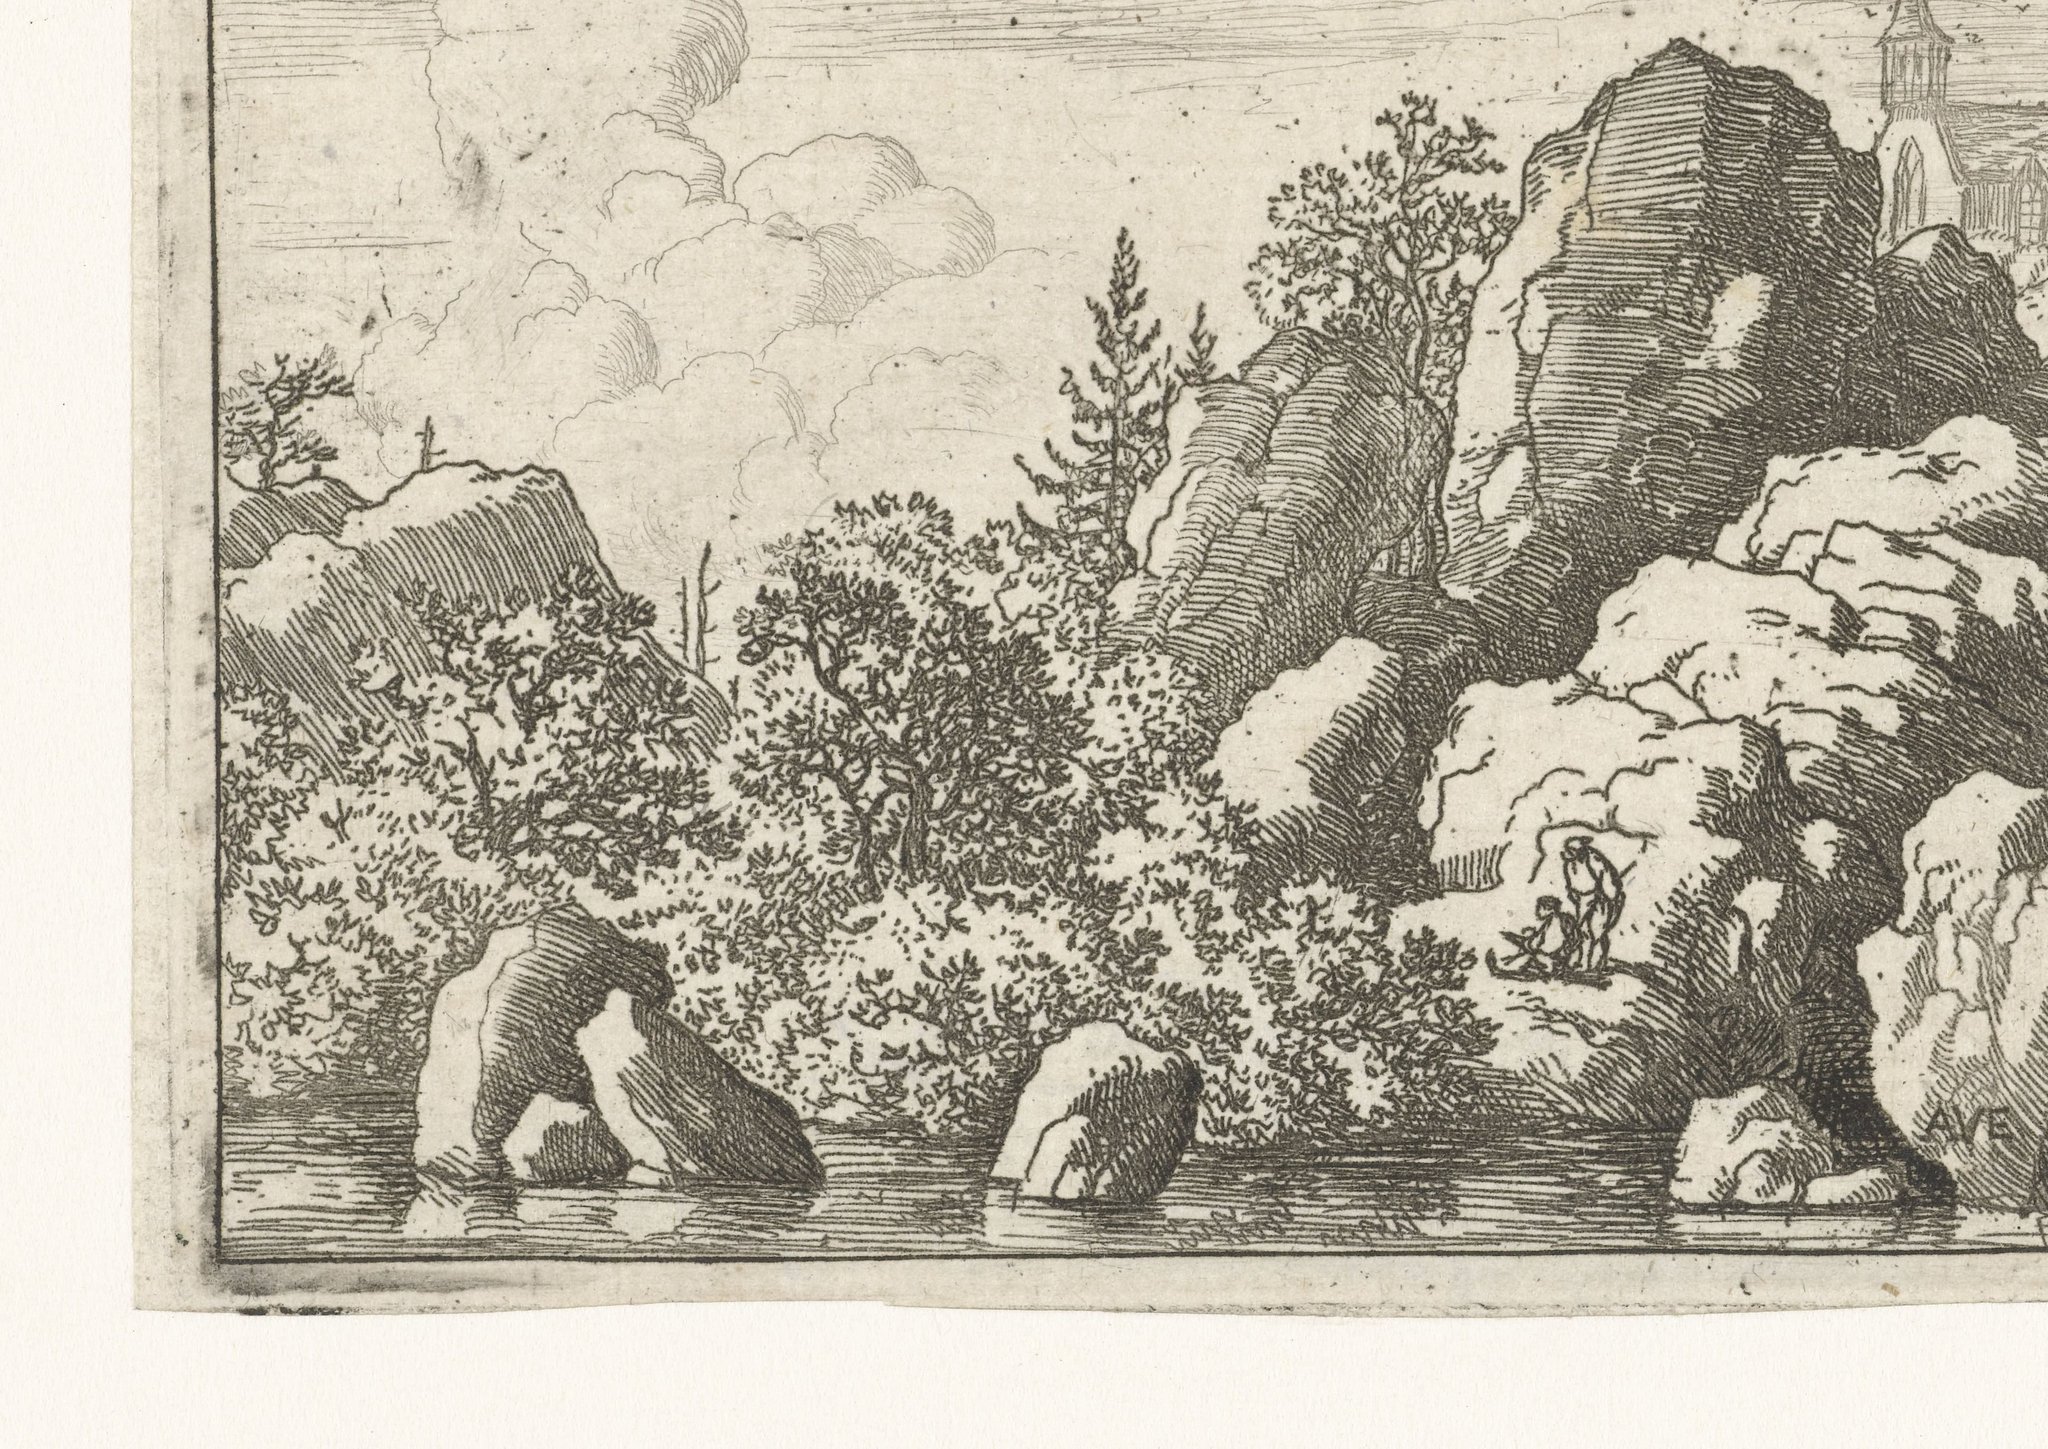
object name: print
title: Landschap met kerk op een berg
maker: allaert van everdingen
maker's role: draughtsman, painter, print maker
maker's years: 1621-1675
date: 1631-1675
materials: paper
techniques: etching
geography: netherlands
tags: rocks (+ landscape with figures, staffage)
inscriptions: collector's mark: Lugt 2228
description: Rotslandschap met water op de voorgrond. Naast struikgewas staat een voorovergebogen figuur bij een zittend persoon. Op de achtergrond een kerk.